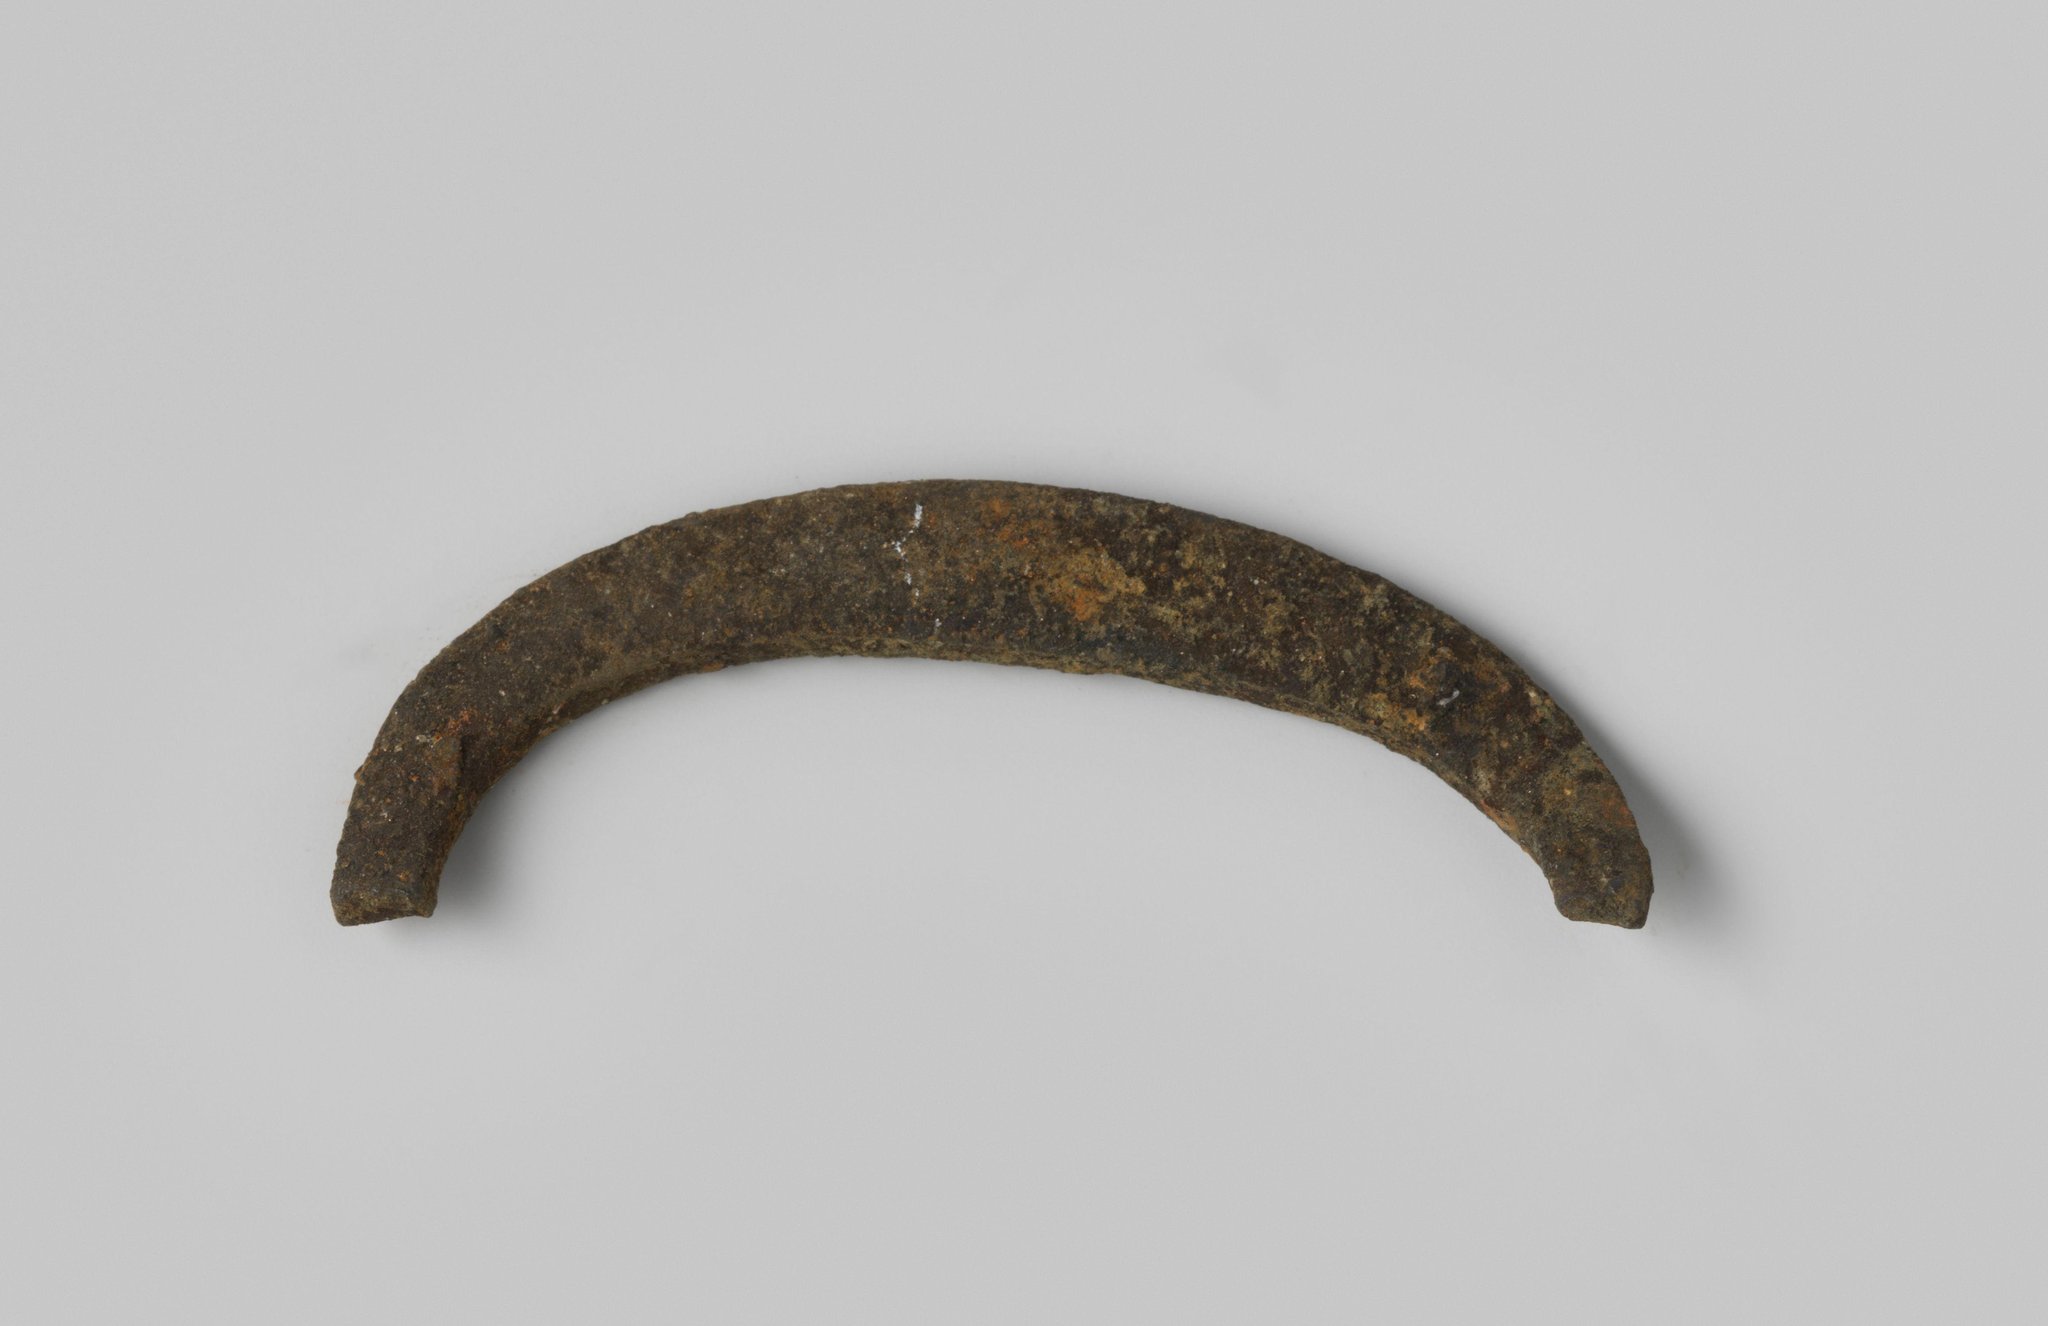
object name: belt buckle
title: Fragment riemgesp uit het wrak van de Oost-Indiëvaarder Hollandia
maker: Anonymous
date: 1700-1743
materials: copper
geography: netherlands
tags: verenigde oostindische compagnie, hollandia (schip), annet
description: D-shaped, fragm of ring, id. NG 1979-182H2177, belt buckle.